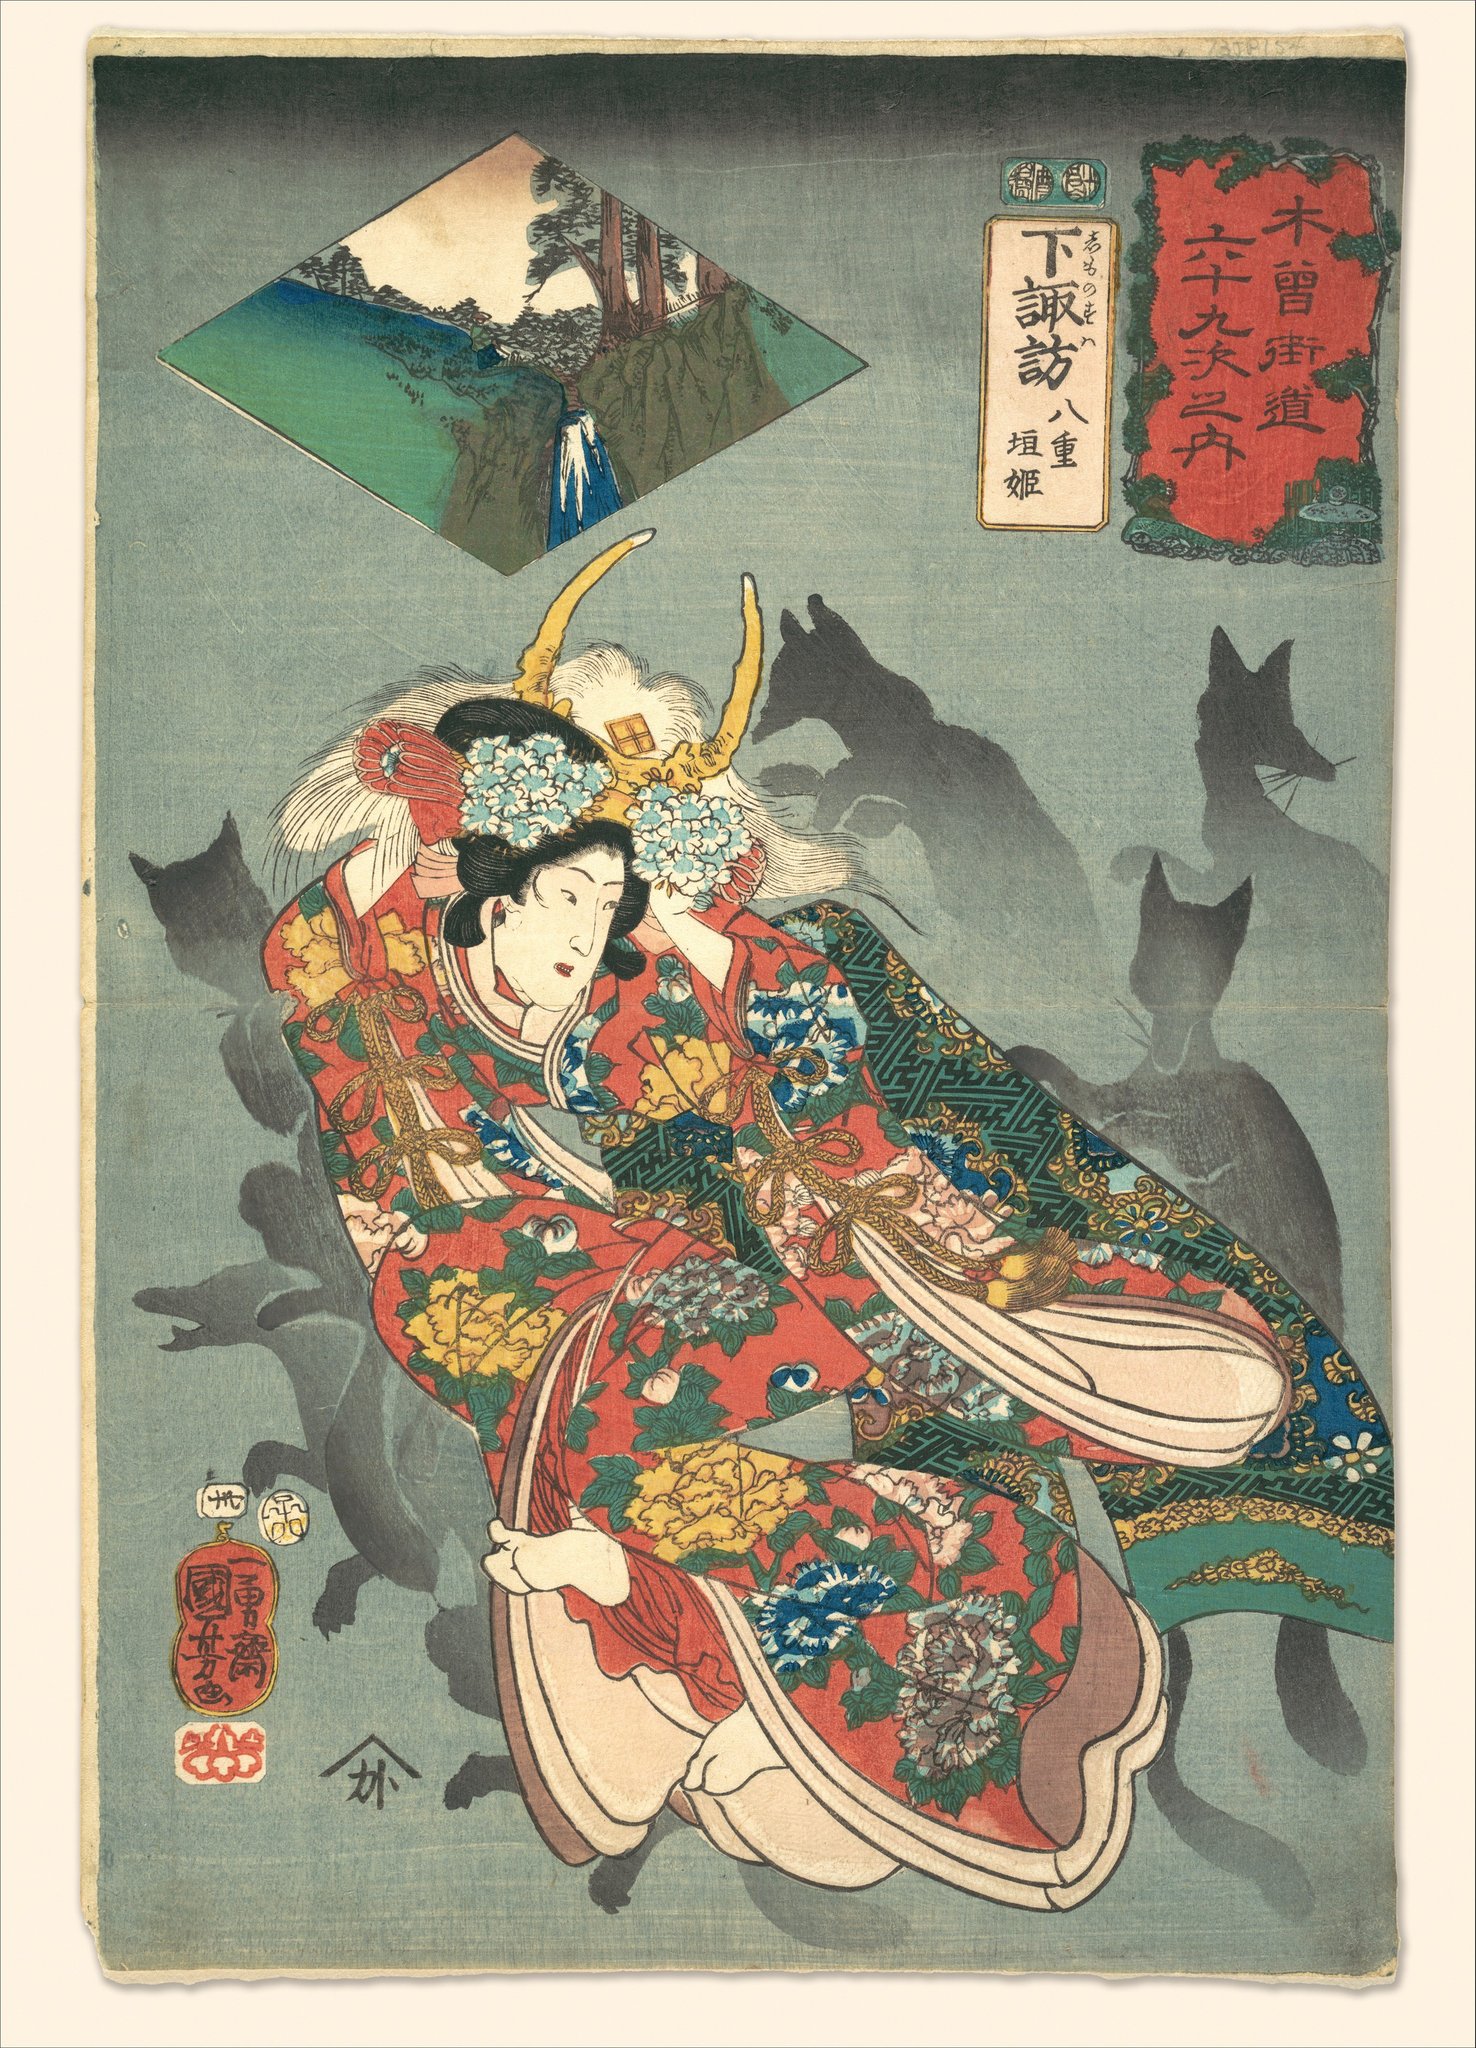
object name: print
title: Princess Yaegaki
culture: japanese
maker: utagawa kuniyoshi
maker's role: artist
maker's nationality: japanese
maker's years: 1797-1861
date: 1801-1900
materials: ink, paper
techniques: woodblock print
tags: animals,dresses,princesses